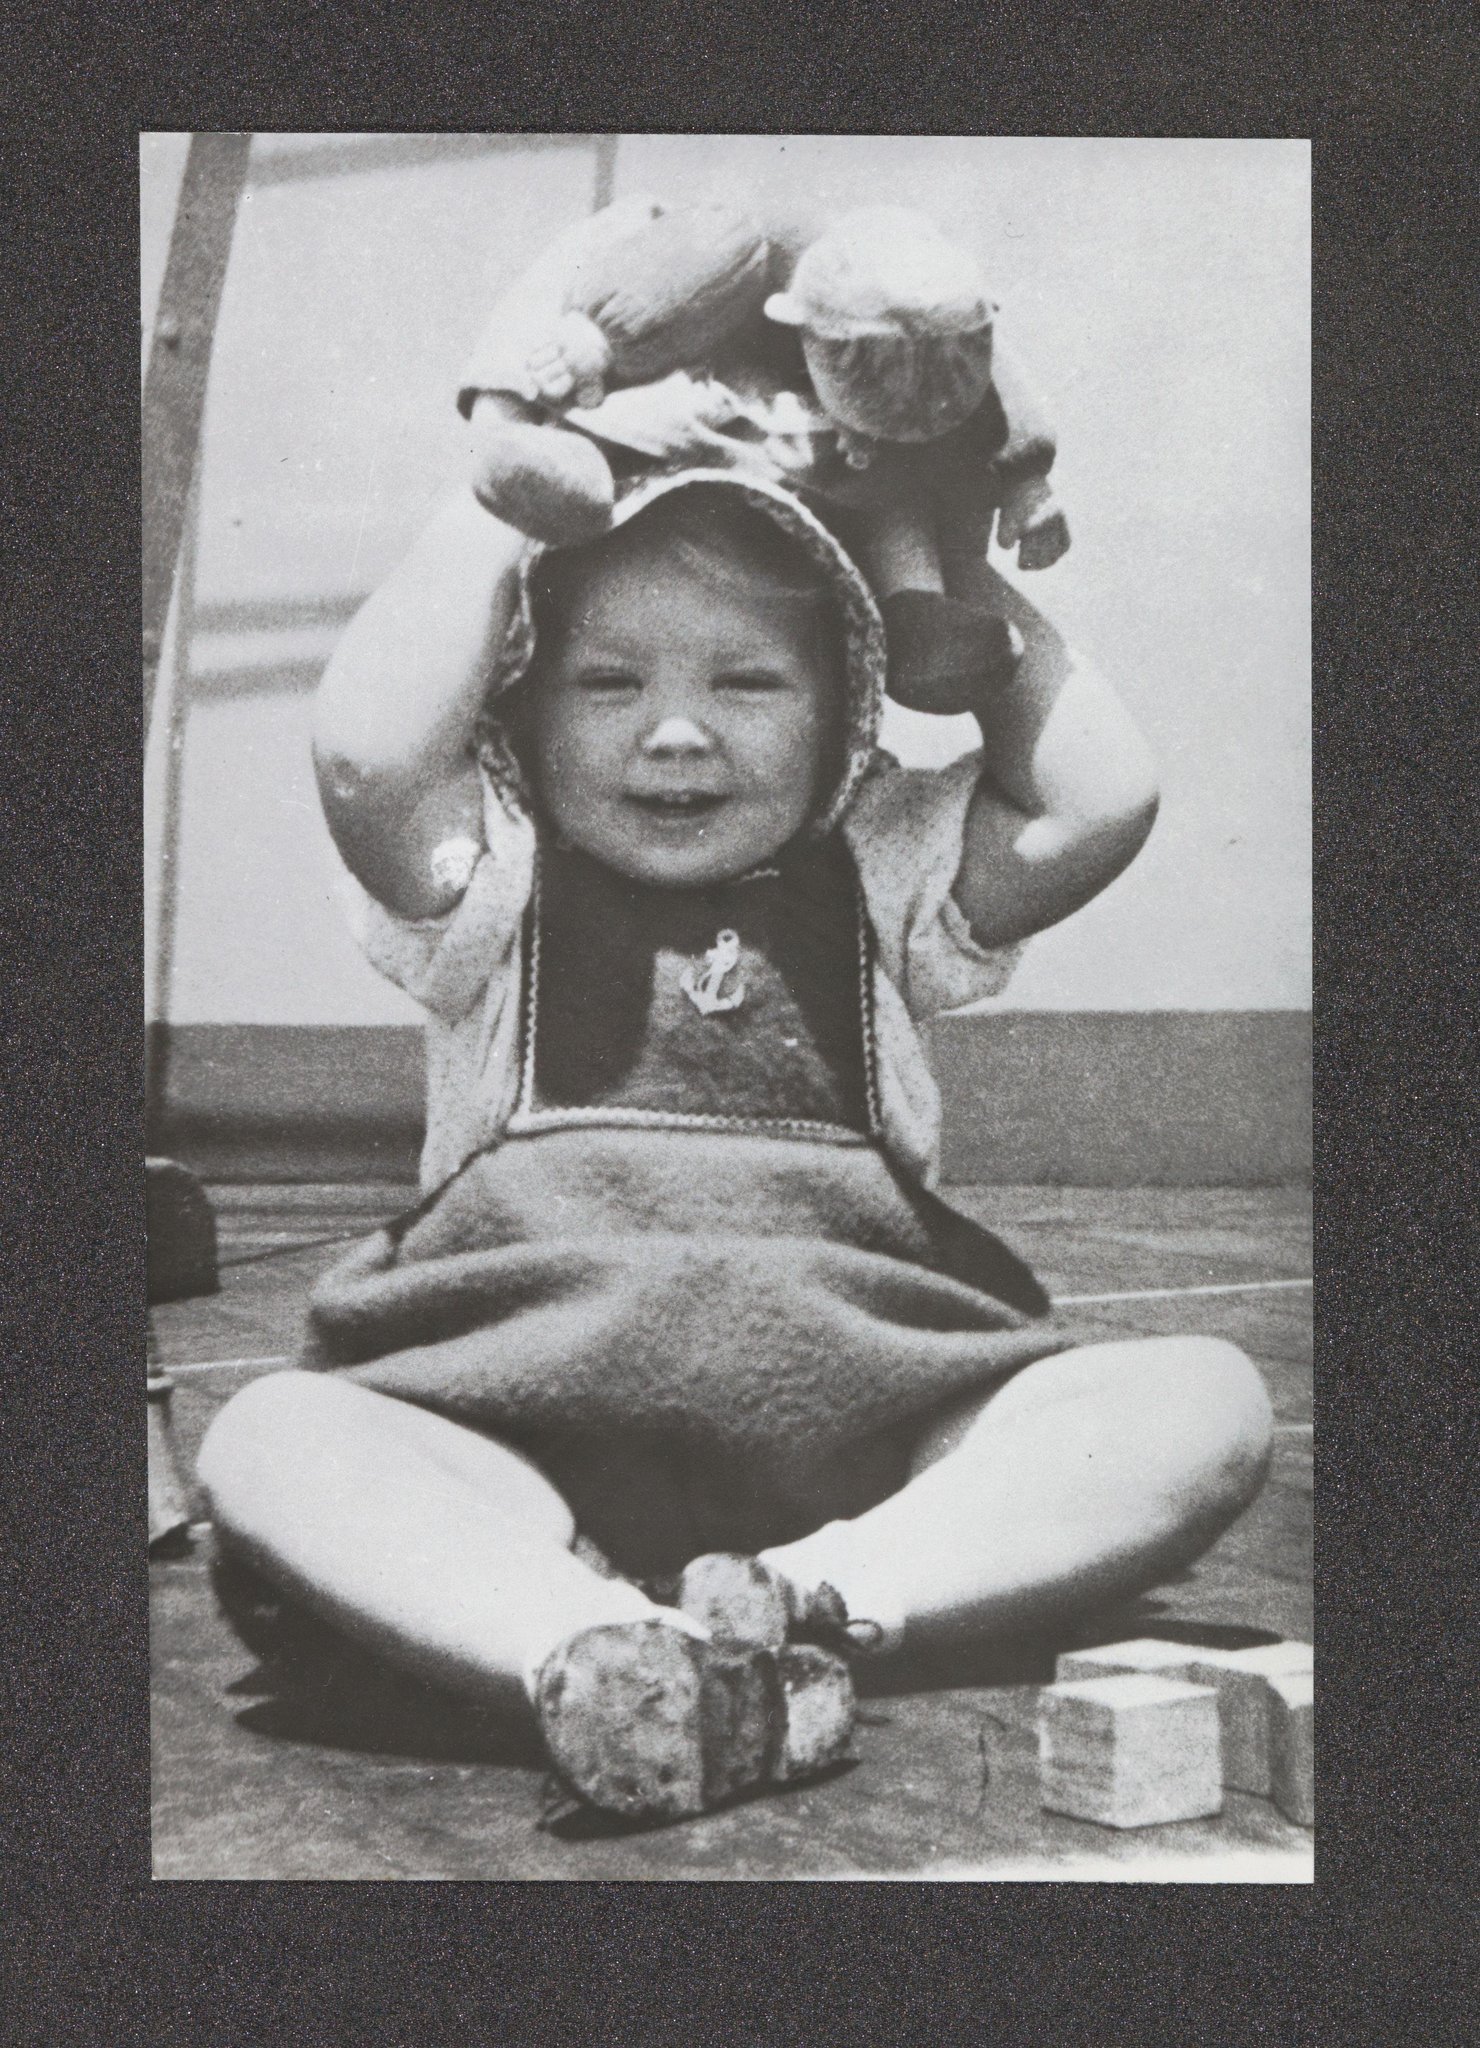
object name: photograph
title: Portret van koningin Beatrix als kind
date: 1959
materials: photographic support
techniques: gelatin silver print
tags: beatrix (koningin der nederlanden)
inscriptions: stamp: ‘Saturday 31st, 1959, H.R.H. Crown Princess Beatrix celebrates her 21st ... to Canada. Photo Anefo 28-1-1959’, inscription: ‘juni 1940’